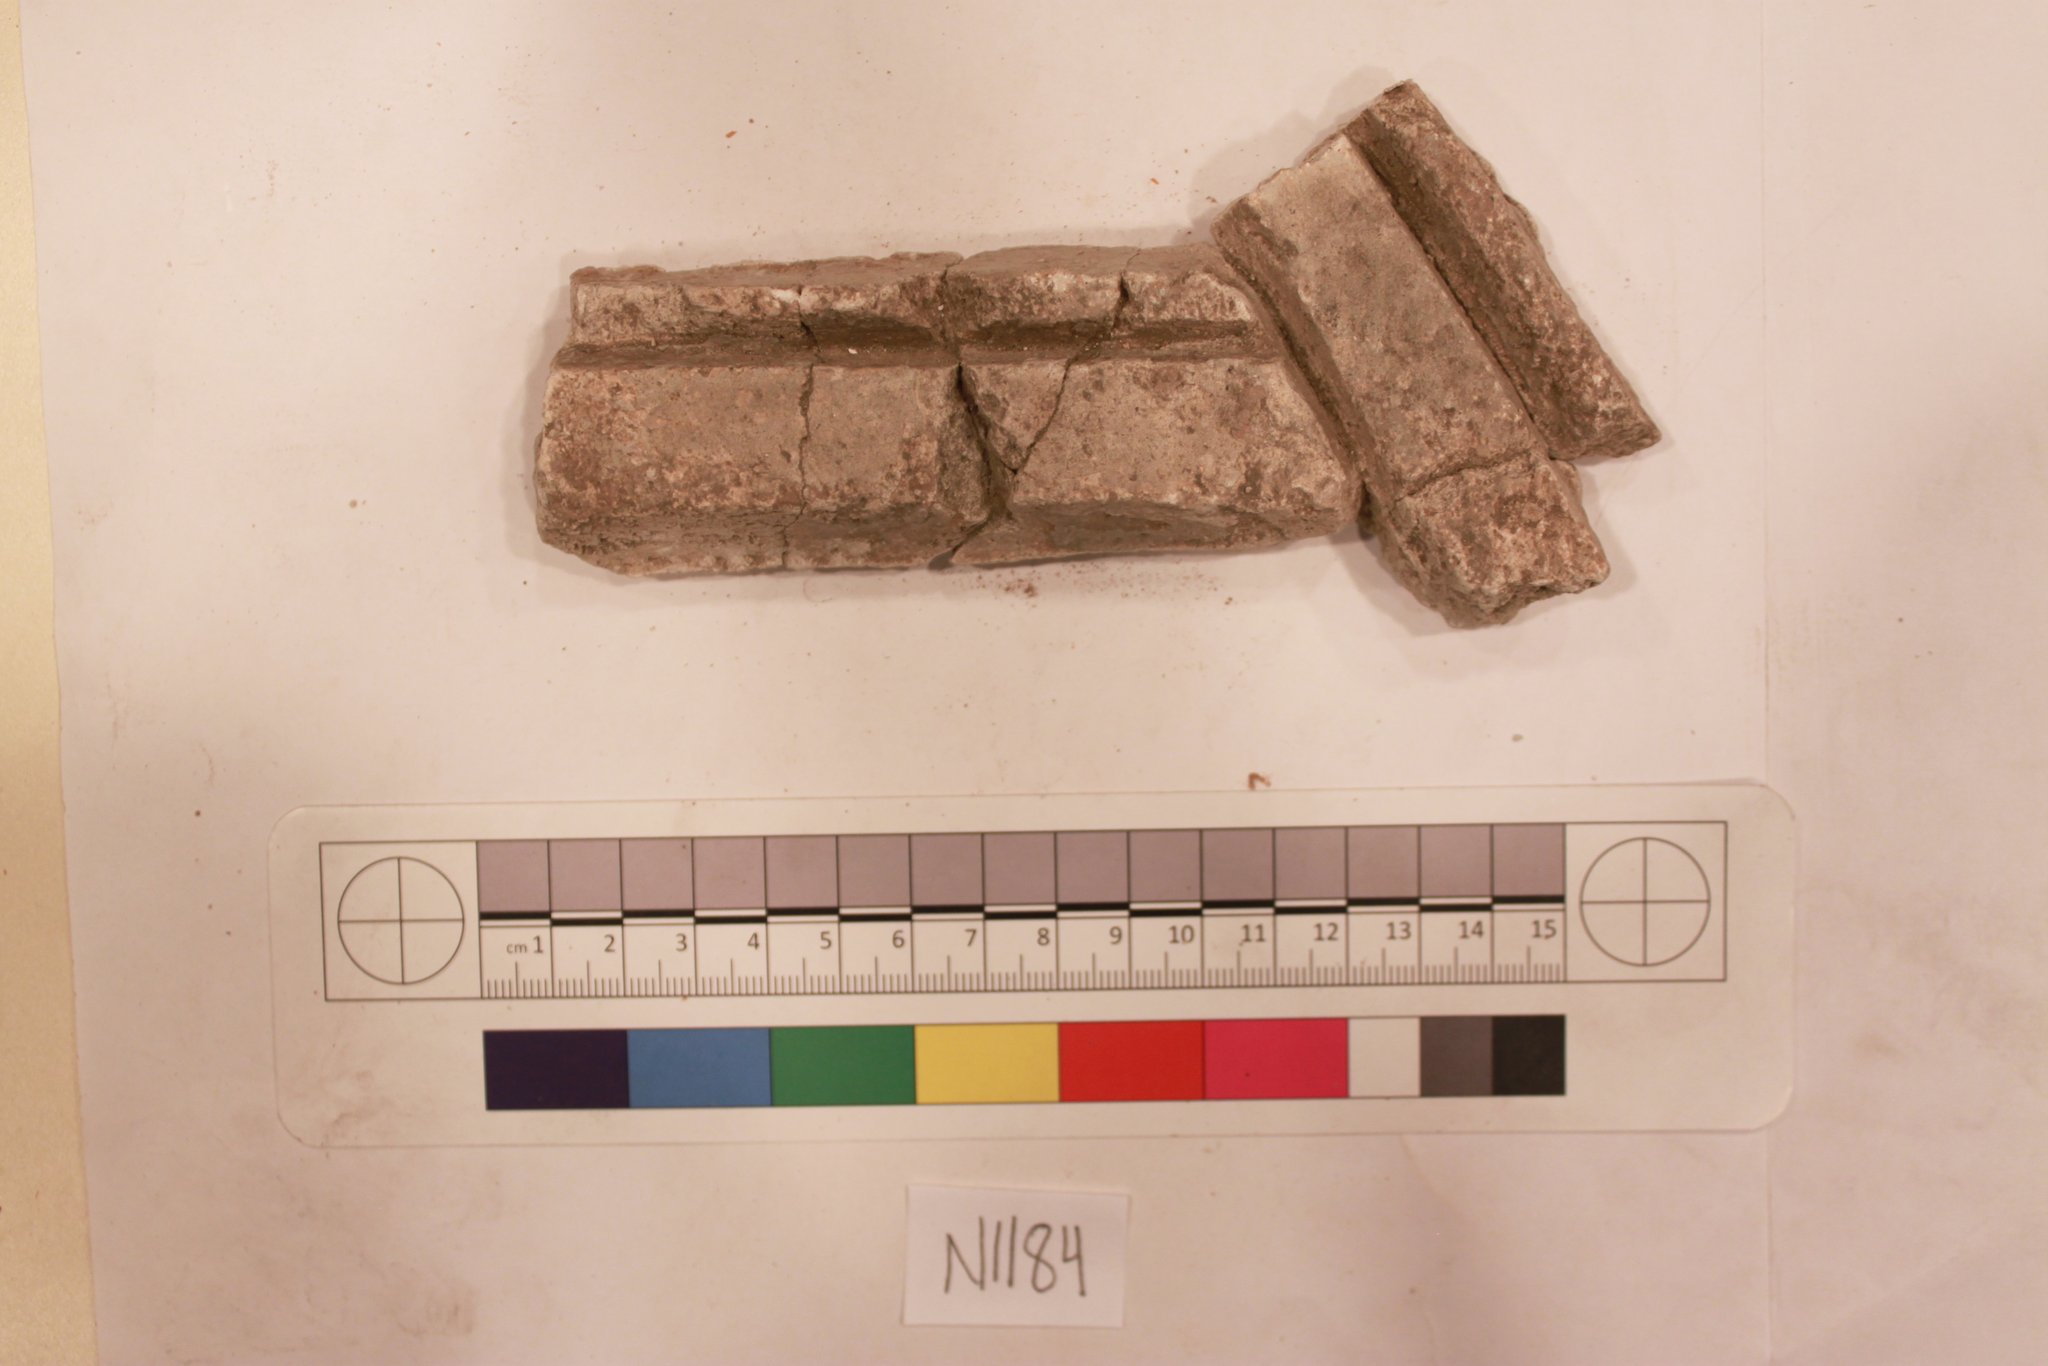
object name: fragment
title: Stucco Fragment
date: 701-1200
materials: plaster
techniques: carving, painting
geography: iran